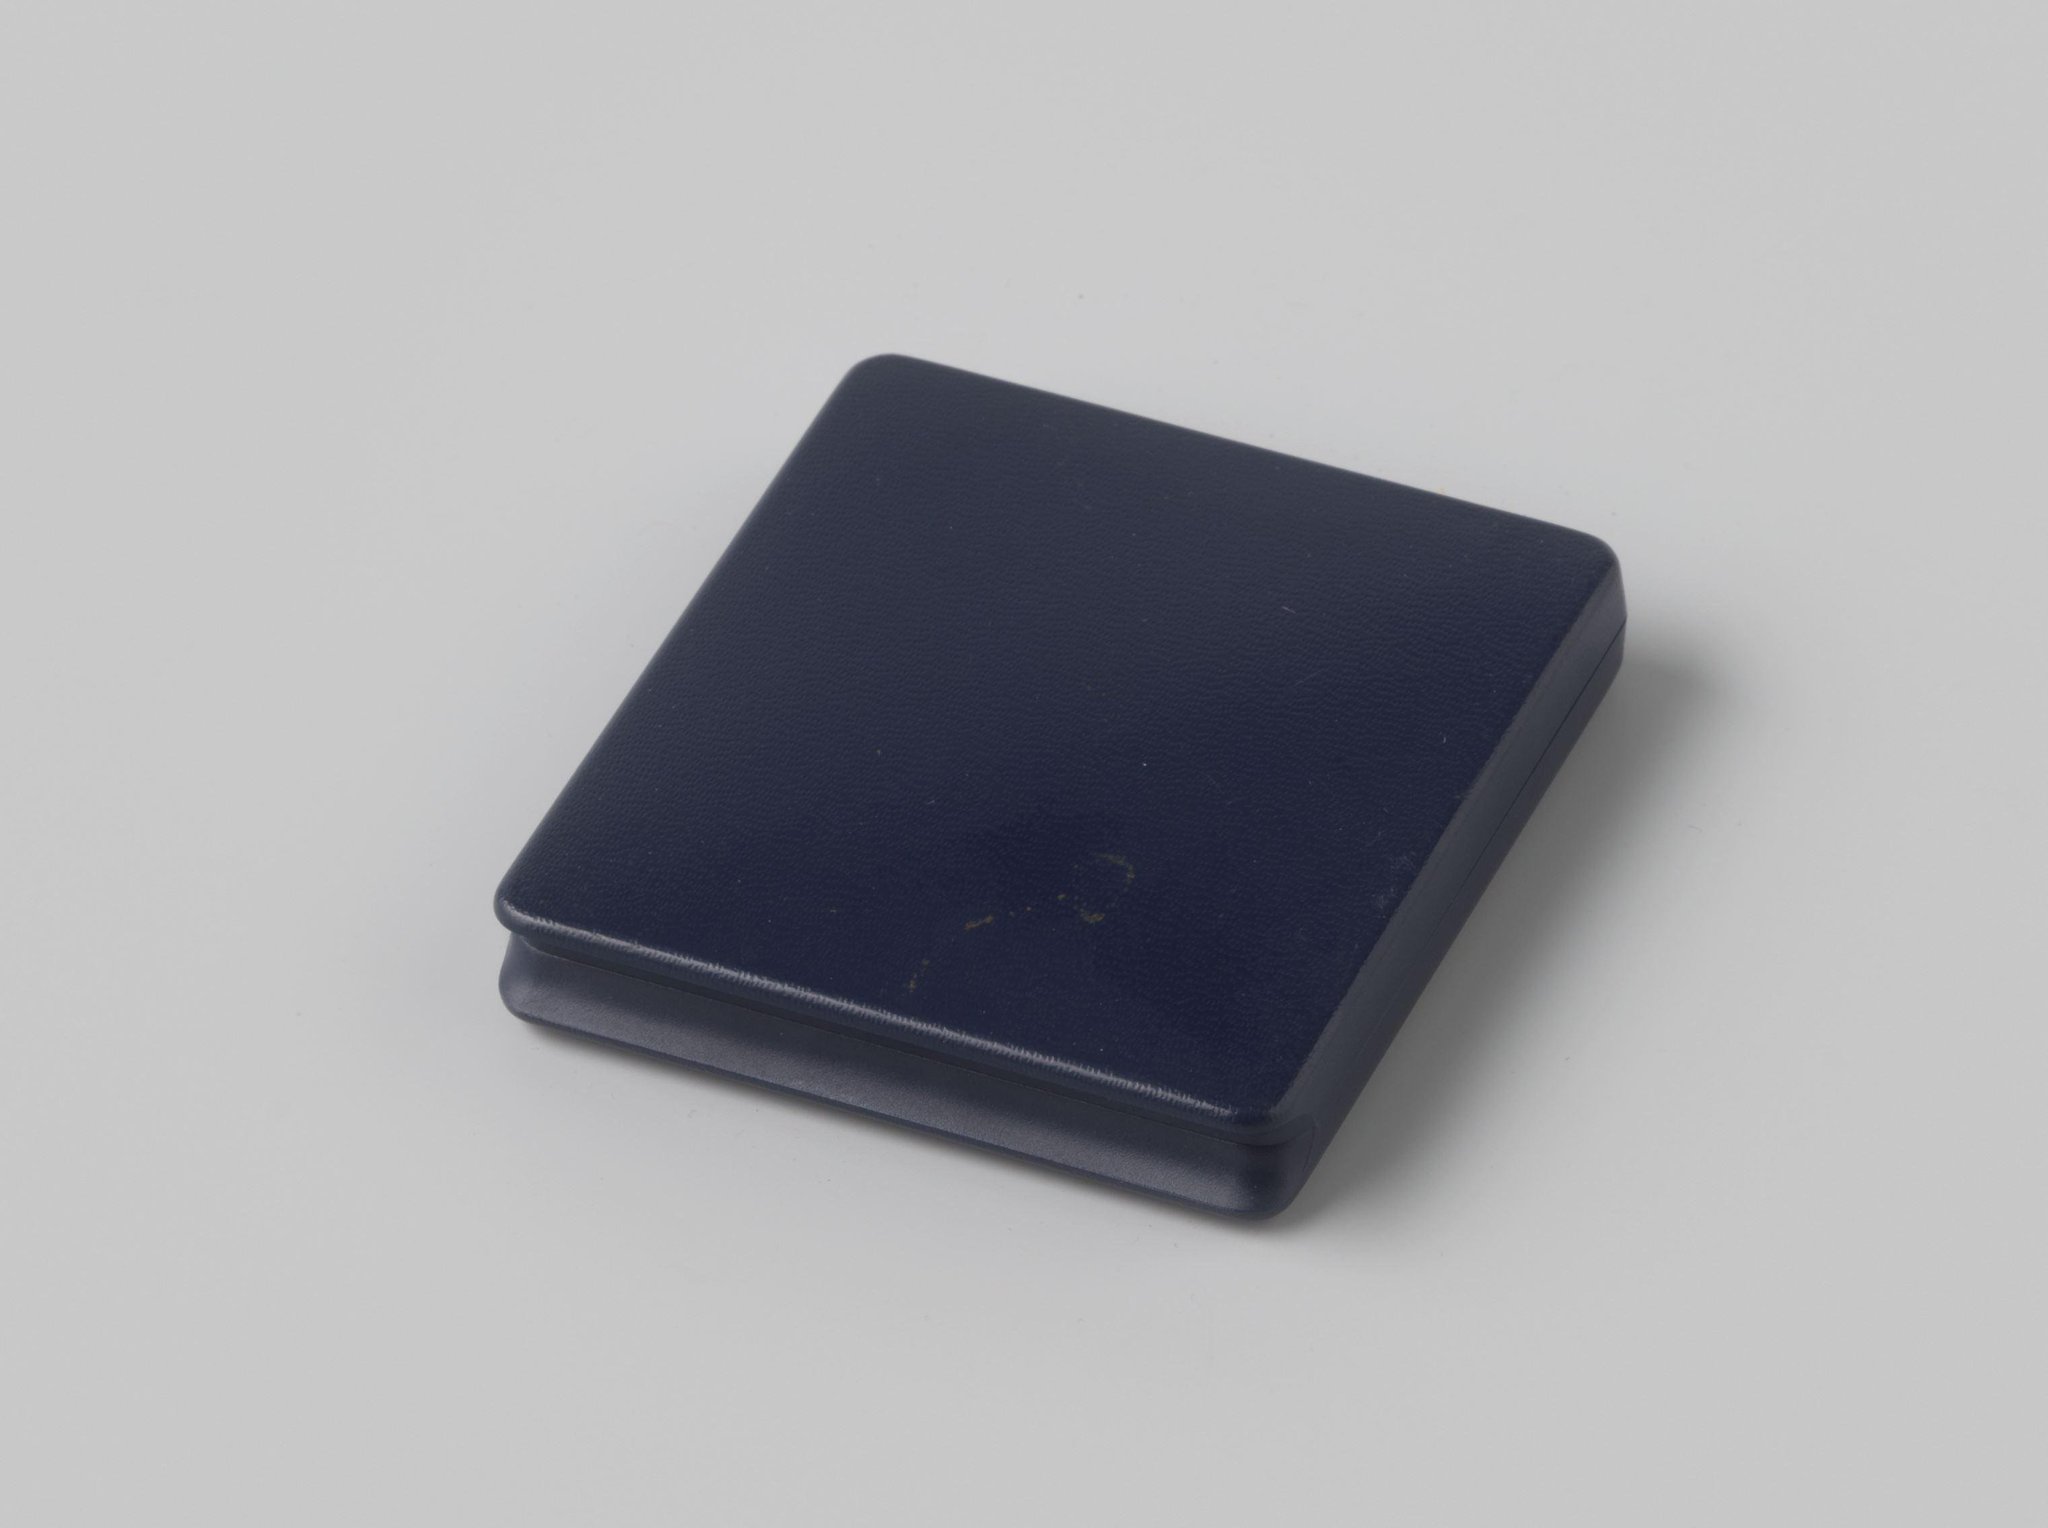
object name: box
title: Doosje behorend bij een penning van de Nationale Visserijdagen te Den Helder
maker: Anonymous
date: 1986-1988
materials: silk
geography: netherlands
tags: den helder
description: Een blauw doosje van kunststof, waarvan de binnenzijde van het deksel bekleed is met witte zijde en de binnenzijde van de bodem met blauwe stof, waarin ronde een uitsparing is opengelaten.